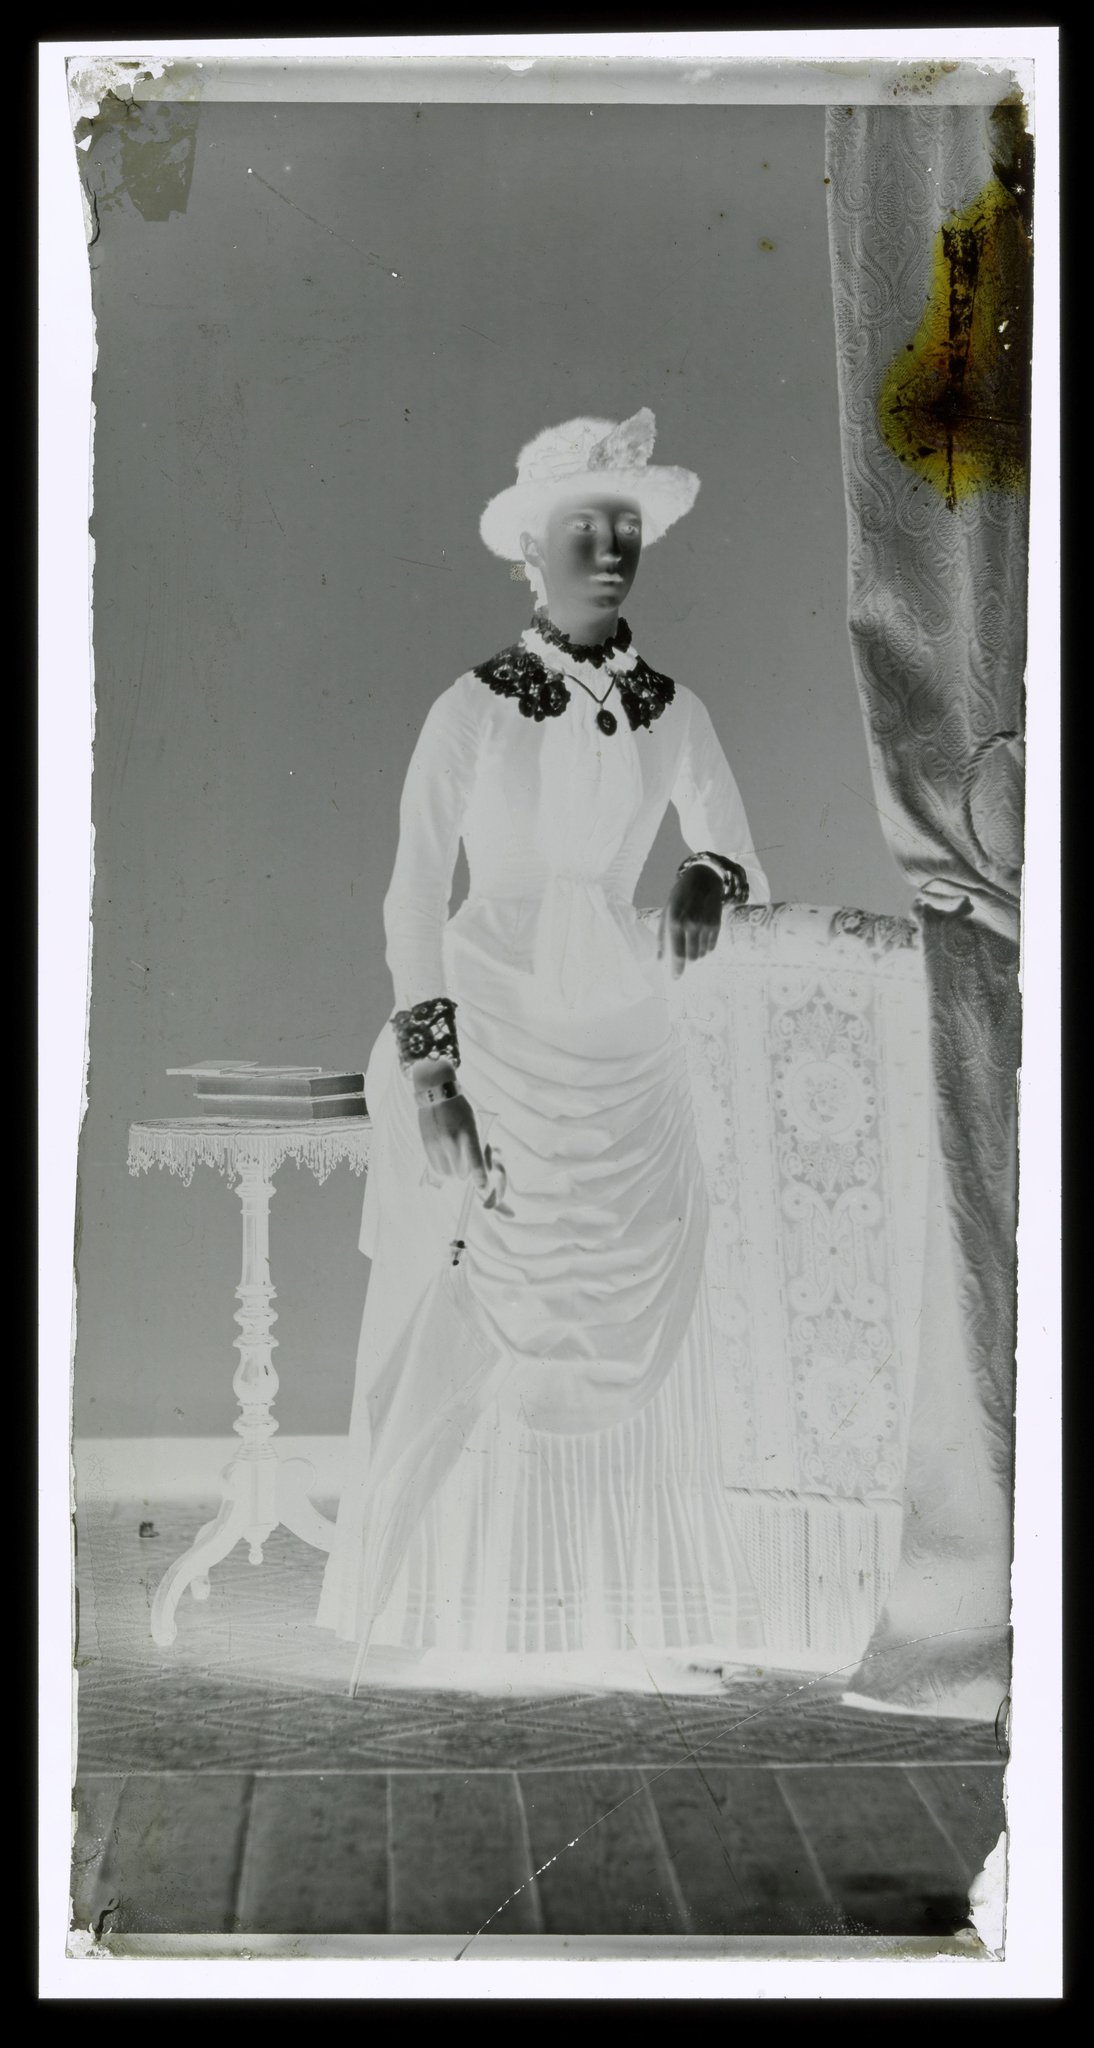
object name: glasnegatief, glasplaatnegatief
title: Portret van een onbekende vrouw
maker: laurens lodewijk kleijn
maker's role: draughtsman, painter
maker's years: 1826-1909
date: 1865-1900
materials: glass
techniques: collodion process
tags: historical persons not known by name - bb - woman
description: Onderdeel van een groep glasnegatieven uit de nalatenschap van de schilder Laurens Lodewijk Kleijn, met stillevens, portretten, zelfportretten en kunstreproducties.